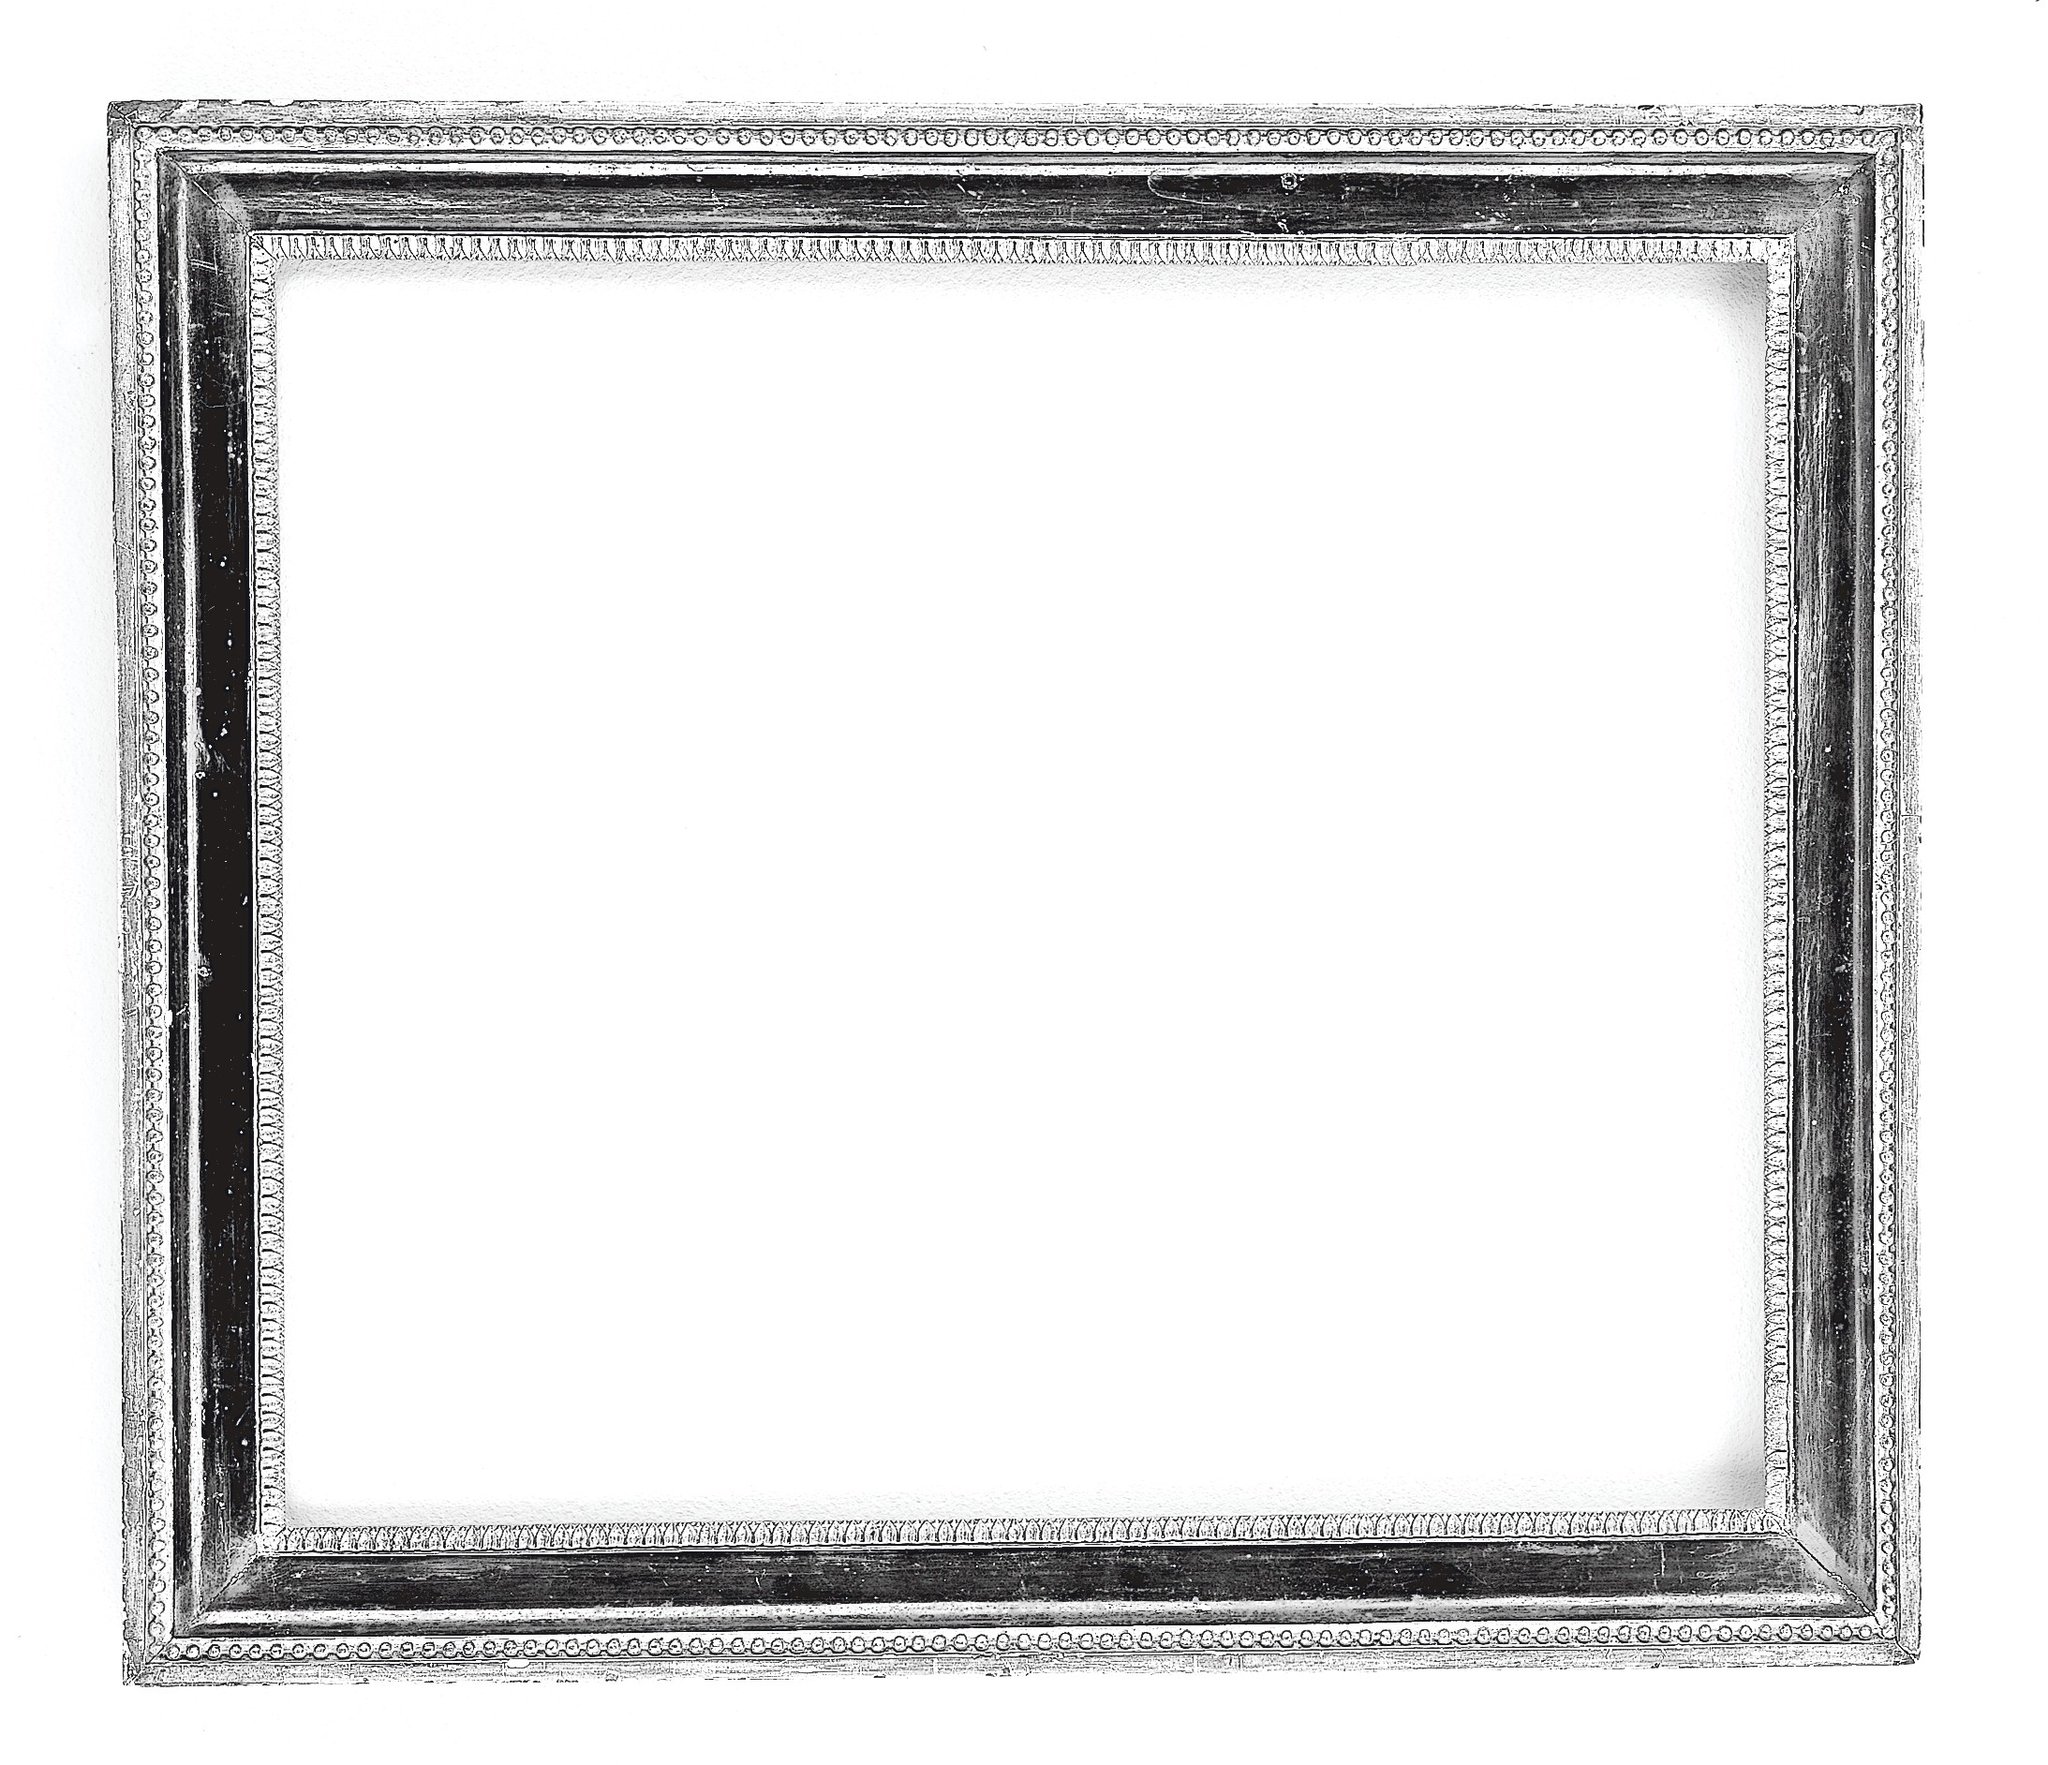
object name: frame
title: Cassetta frame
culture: french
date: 1820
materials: gilt, wood, varnish